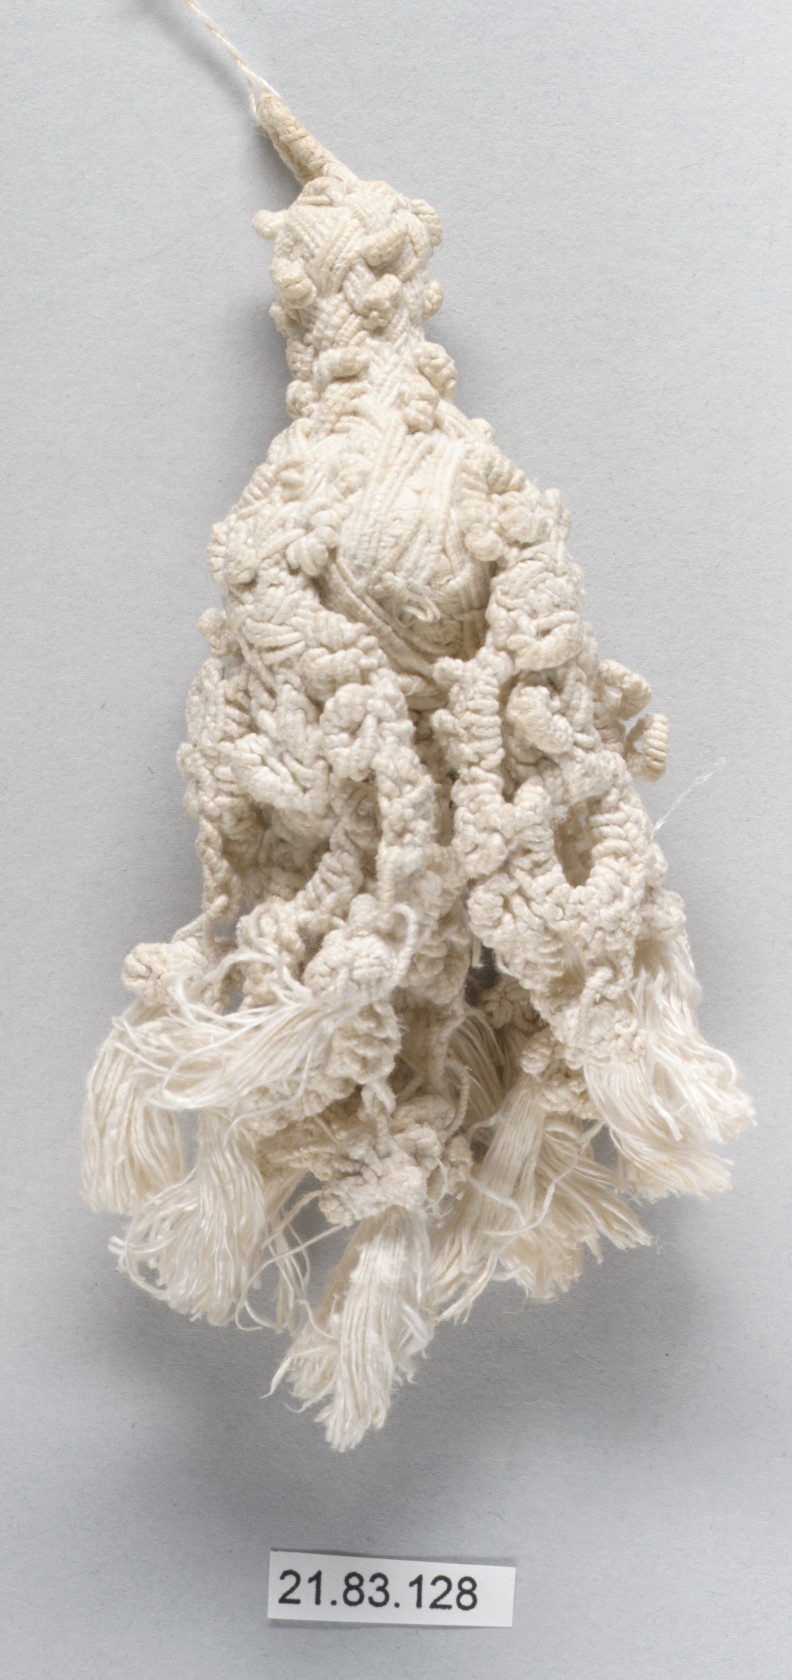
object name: tassel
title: Pair of tassels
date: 1601-1700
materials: linen